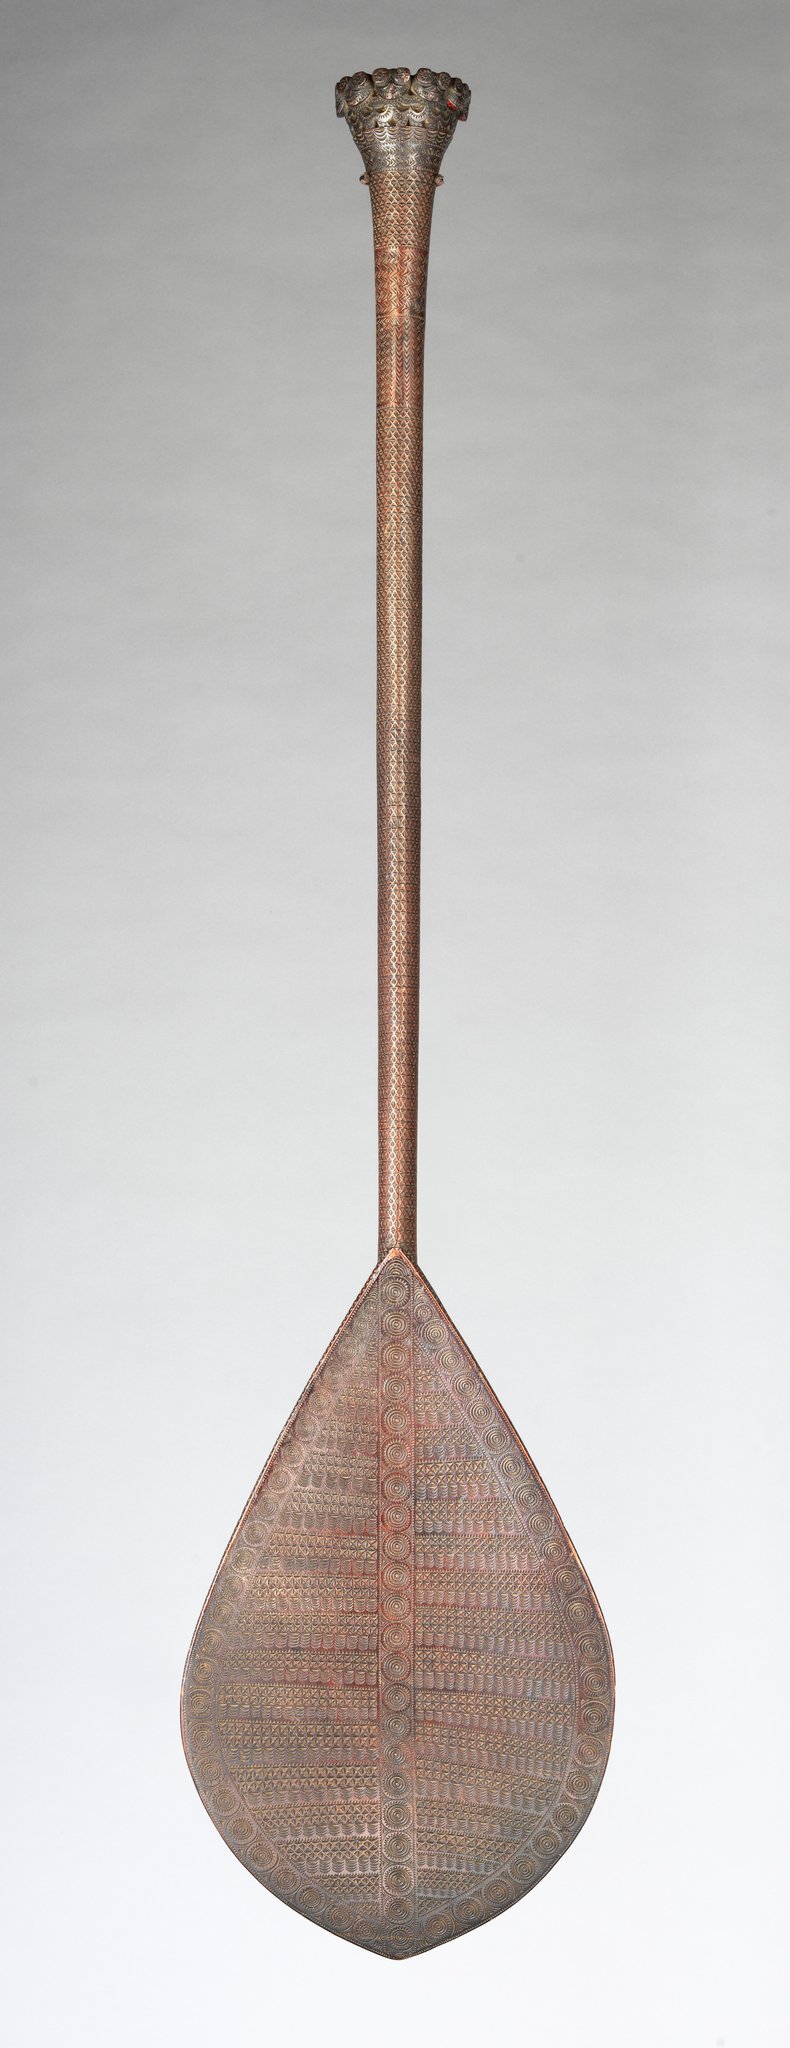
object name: paddle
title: Dance Paddle(?)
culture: austral islanders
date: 1820-1840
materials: wood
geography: french polynesia